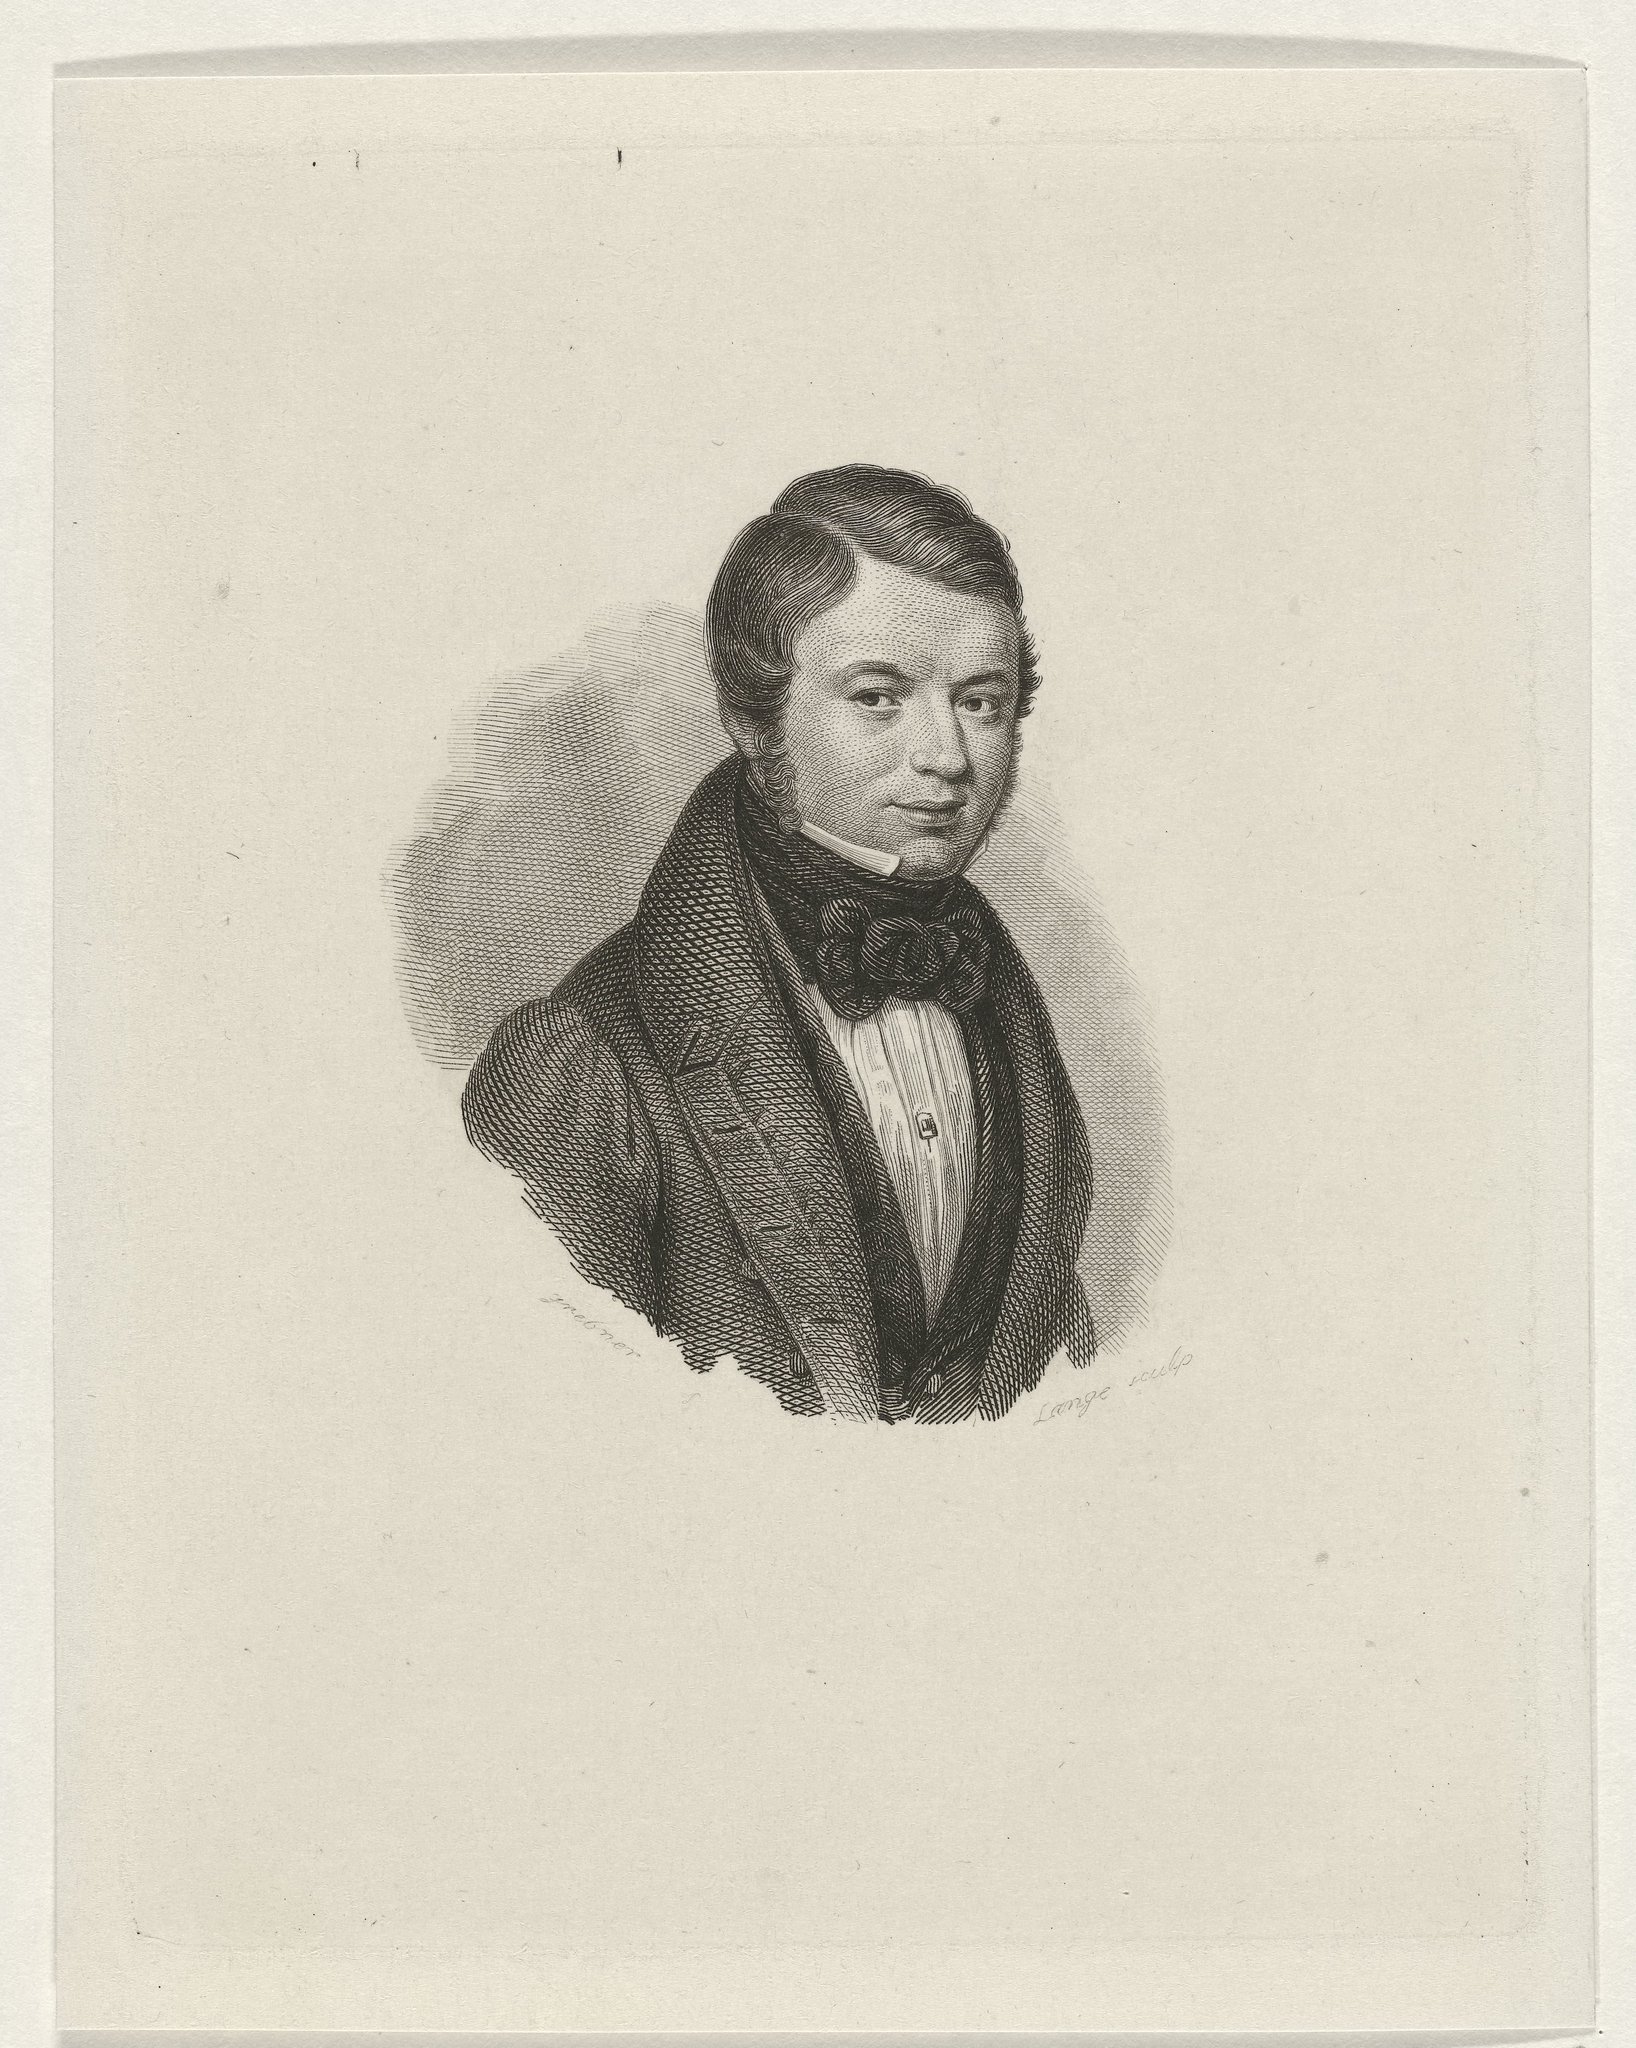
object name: print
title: Portret van Nicolaas Beets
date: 1820-1849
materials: paper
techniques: engraving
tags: haarlem, nicolaas beets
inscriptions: collector's mark: Lugt 2228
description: Portretbuste naar rechts van Nicolaas Beets, dichter en predikant te Heemstede.